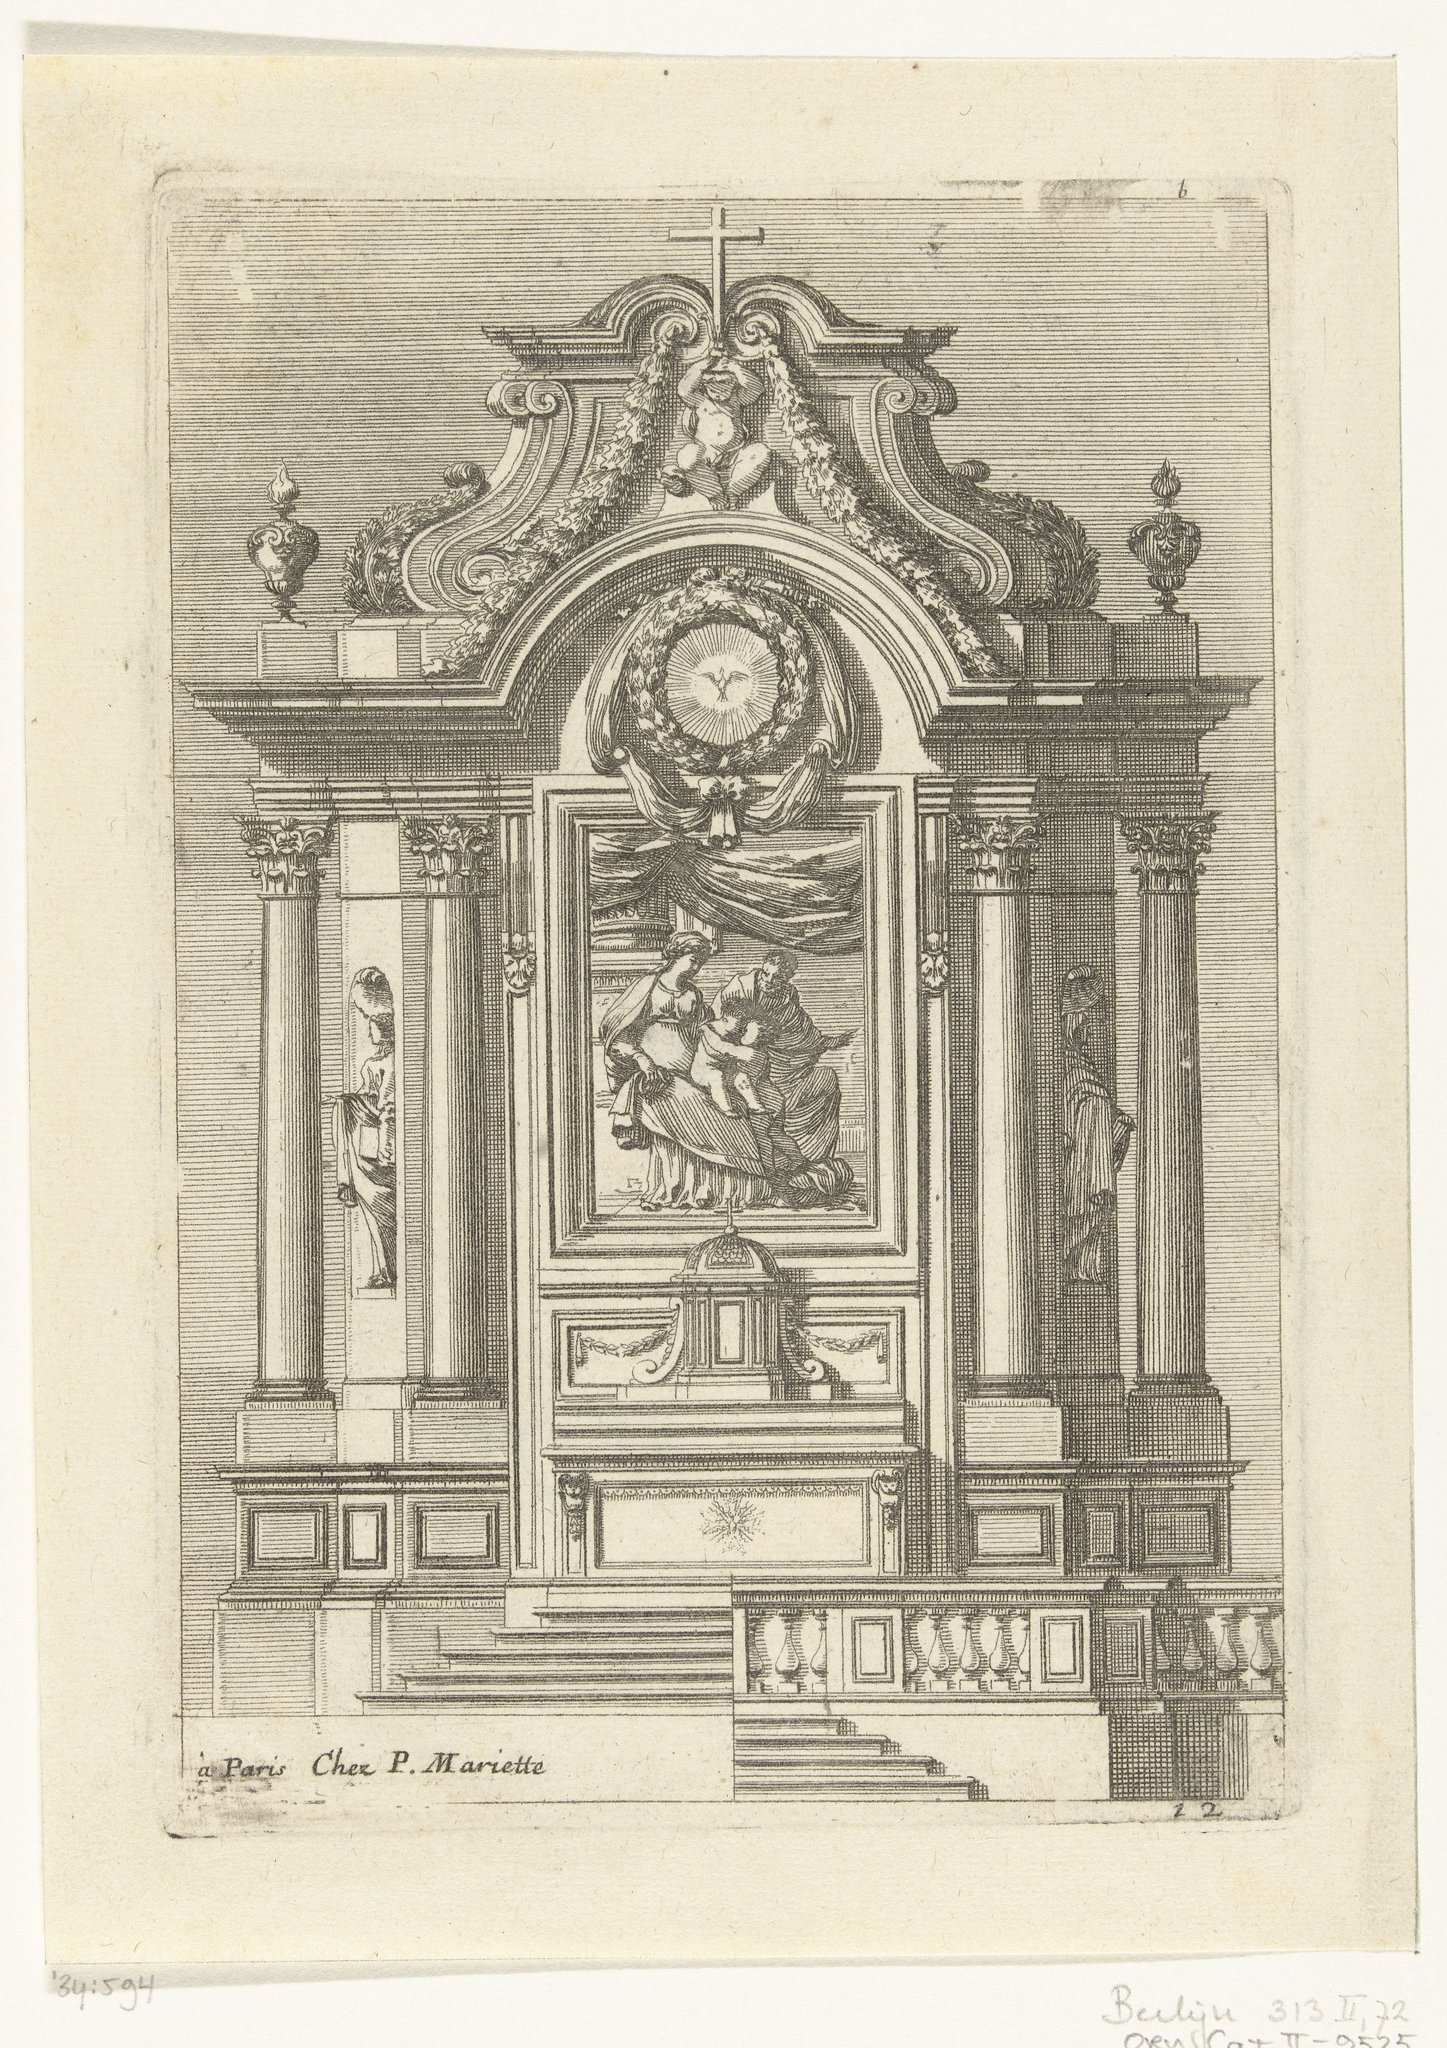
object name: ornament print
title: Authels et Retables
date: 1666-1693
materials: paper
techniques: etching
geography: france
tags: holy family, and derived representations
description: Uit tweede editie van serie met altaren en tabernakels.